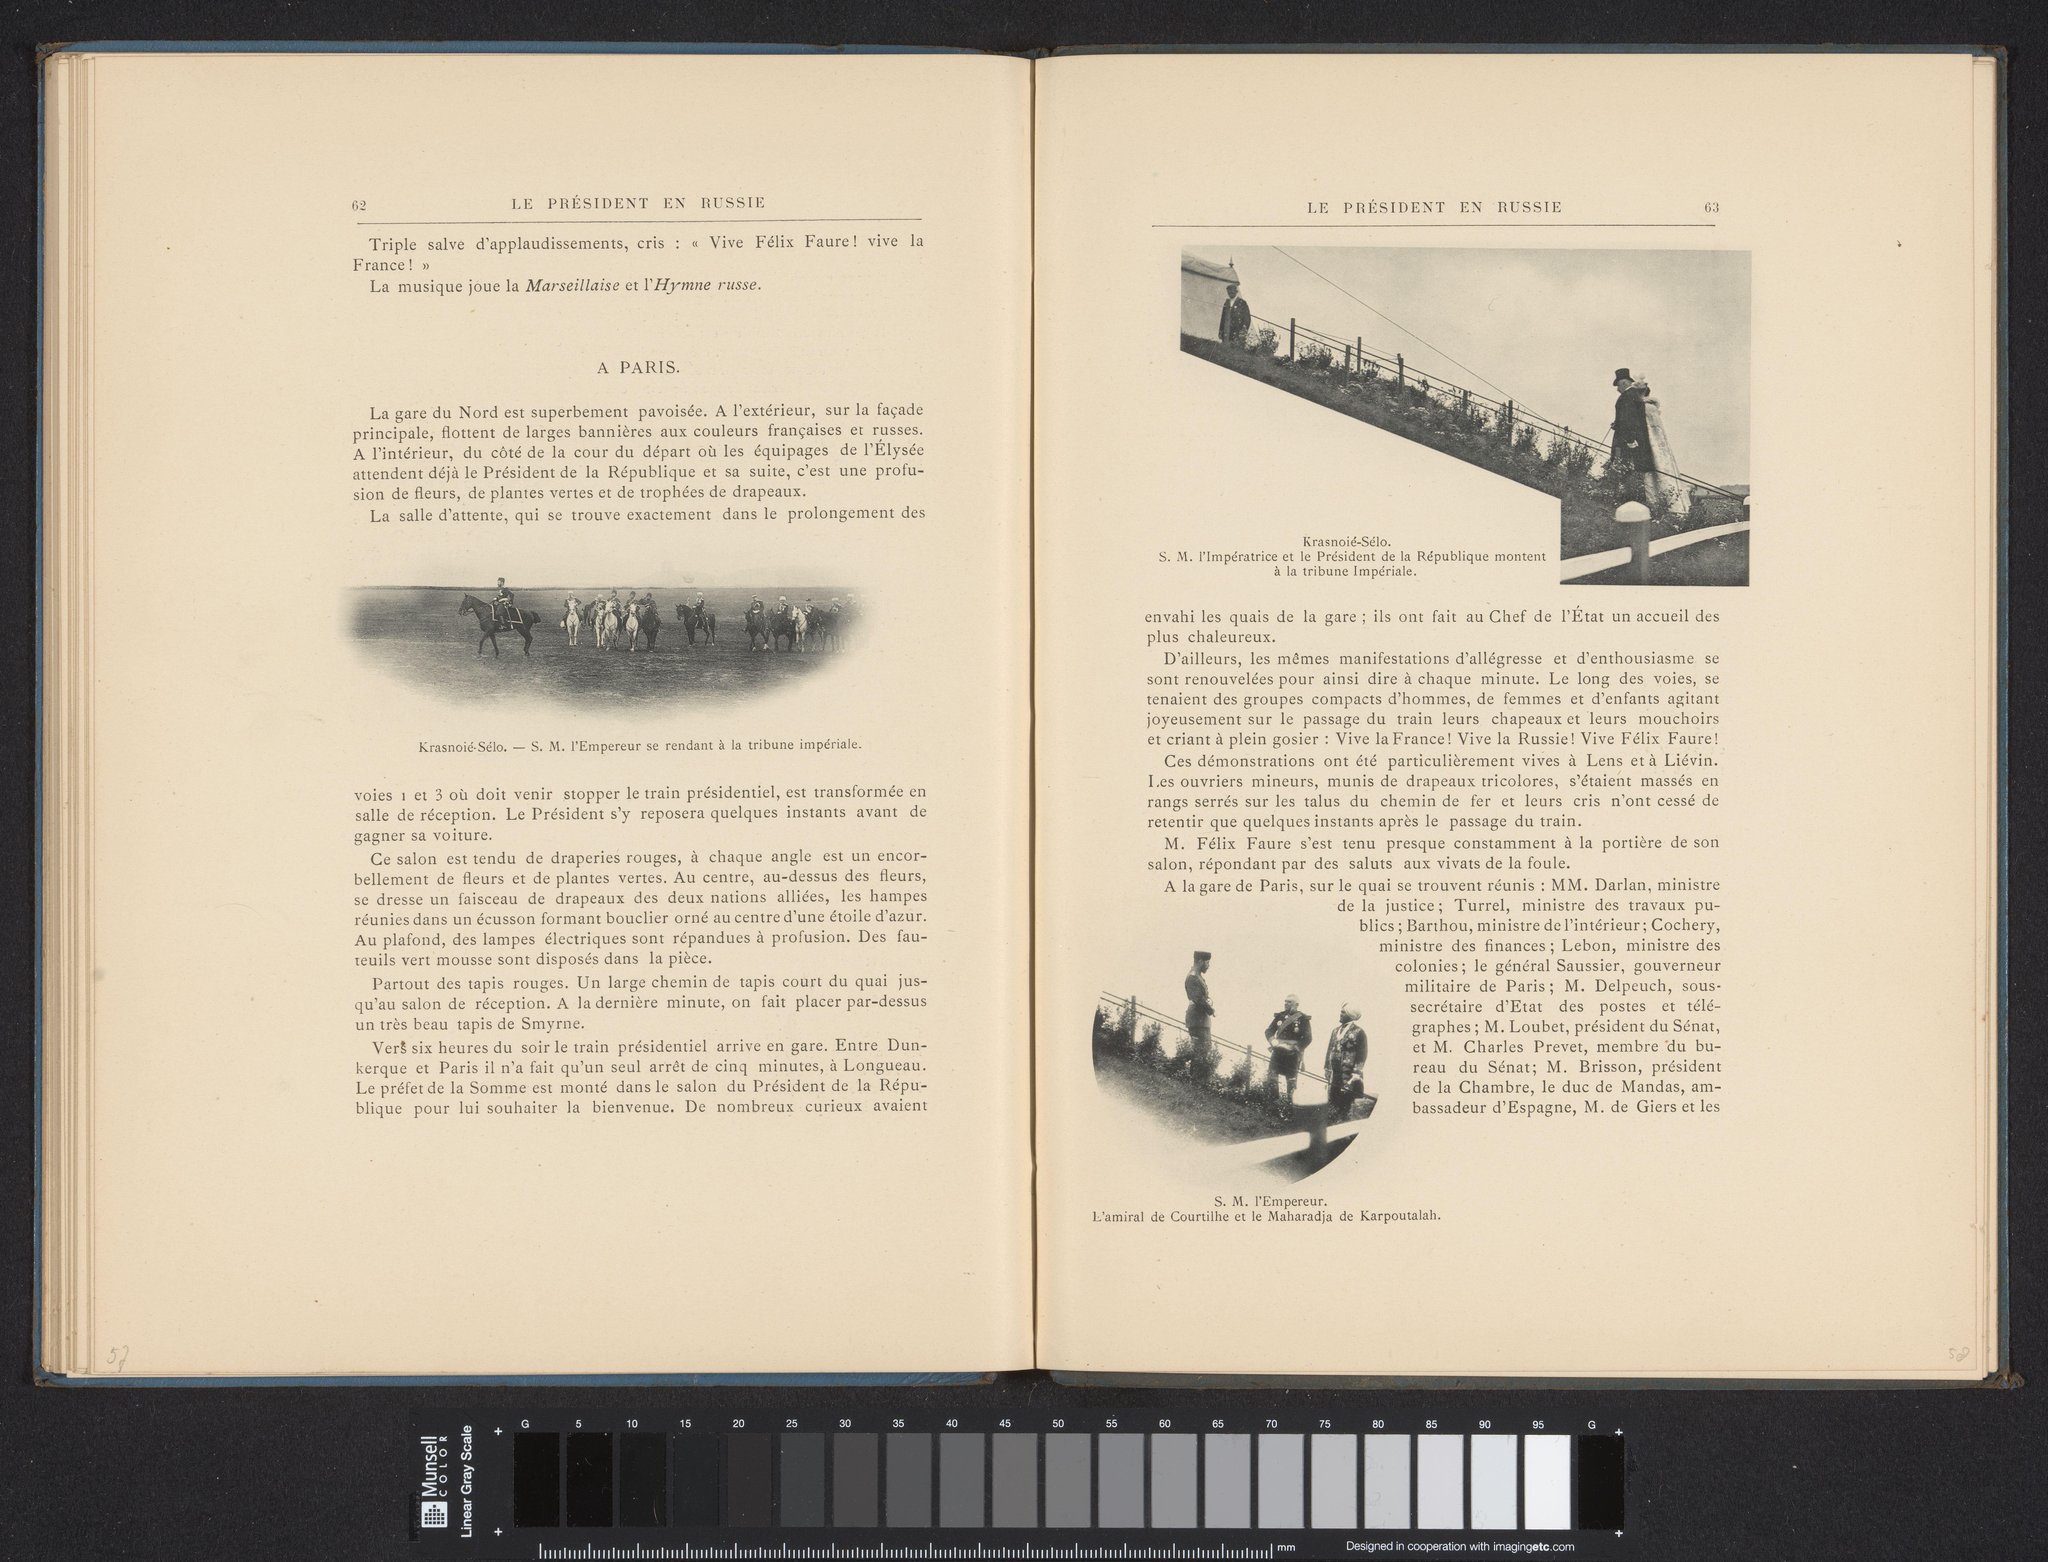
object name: photomechanical print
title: President Félix Faure en tsarina Alexandra Fjodorovna op weg naar de keizerlijke tribune te Krasnoye Selo en een ontmoeting tussen tsaar Nicolaas II van Rusland, admiraal Charles Amet en maharadja Jagatjit Singh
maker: Anonymous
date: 1897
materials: paper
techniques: photograph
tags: paris, jagatjit singh (maharadja van kapurthala), ruler, sovereign - bb - female ruler, ruler, sovereign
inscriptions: inscription: ‘Krasnoié-Sélo-(...) Karpoutalah.’